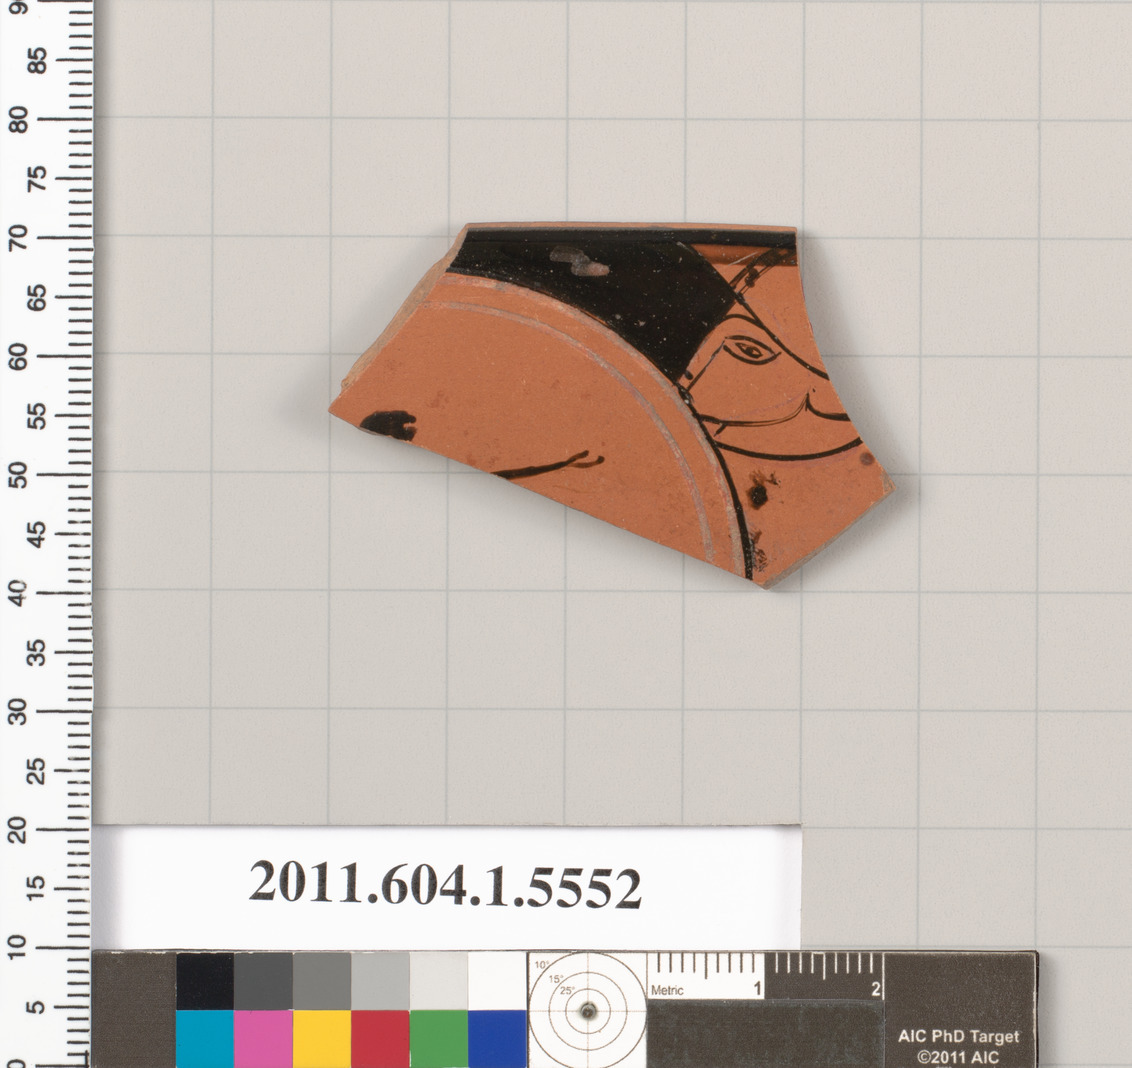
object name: kylix fragment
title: Terracotta rim fragment of a kylix (drinking cup)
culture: greek, attic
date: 520-510 BCE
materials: terracotta